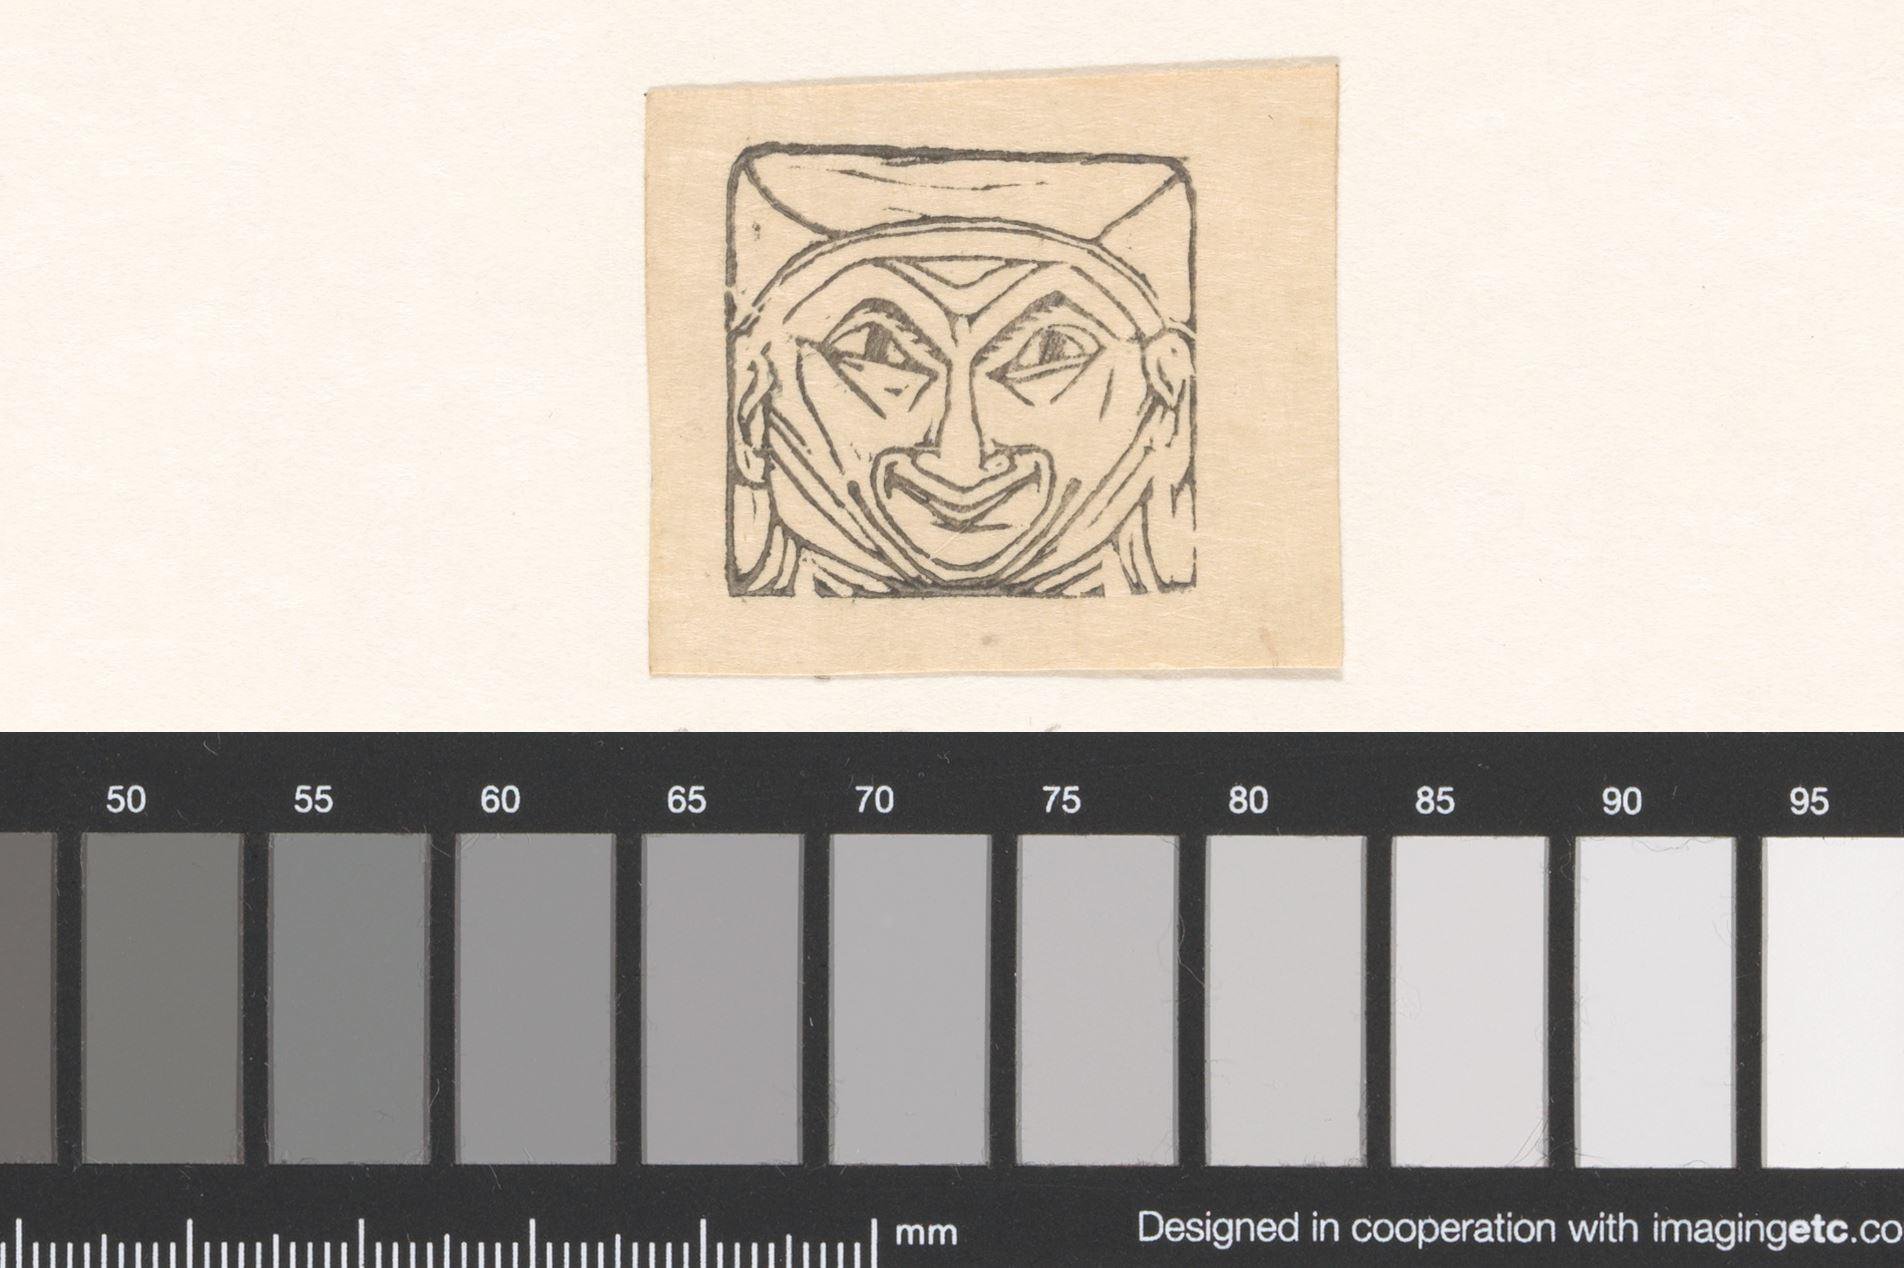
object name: print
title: Vignet met masker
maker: mathieu lauweriks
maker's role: designer, draughtsman, print maker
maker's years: 1864-1932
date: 1895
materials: paper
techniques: woodcut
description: Prent mogelijk gebruikt voor: Licht en waarheid. Orgaan van de vereeniging 'Wie Denkt Overwint'. Amsterdam: Wie Denkt Overwint, 12 oktober 1895.